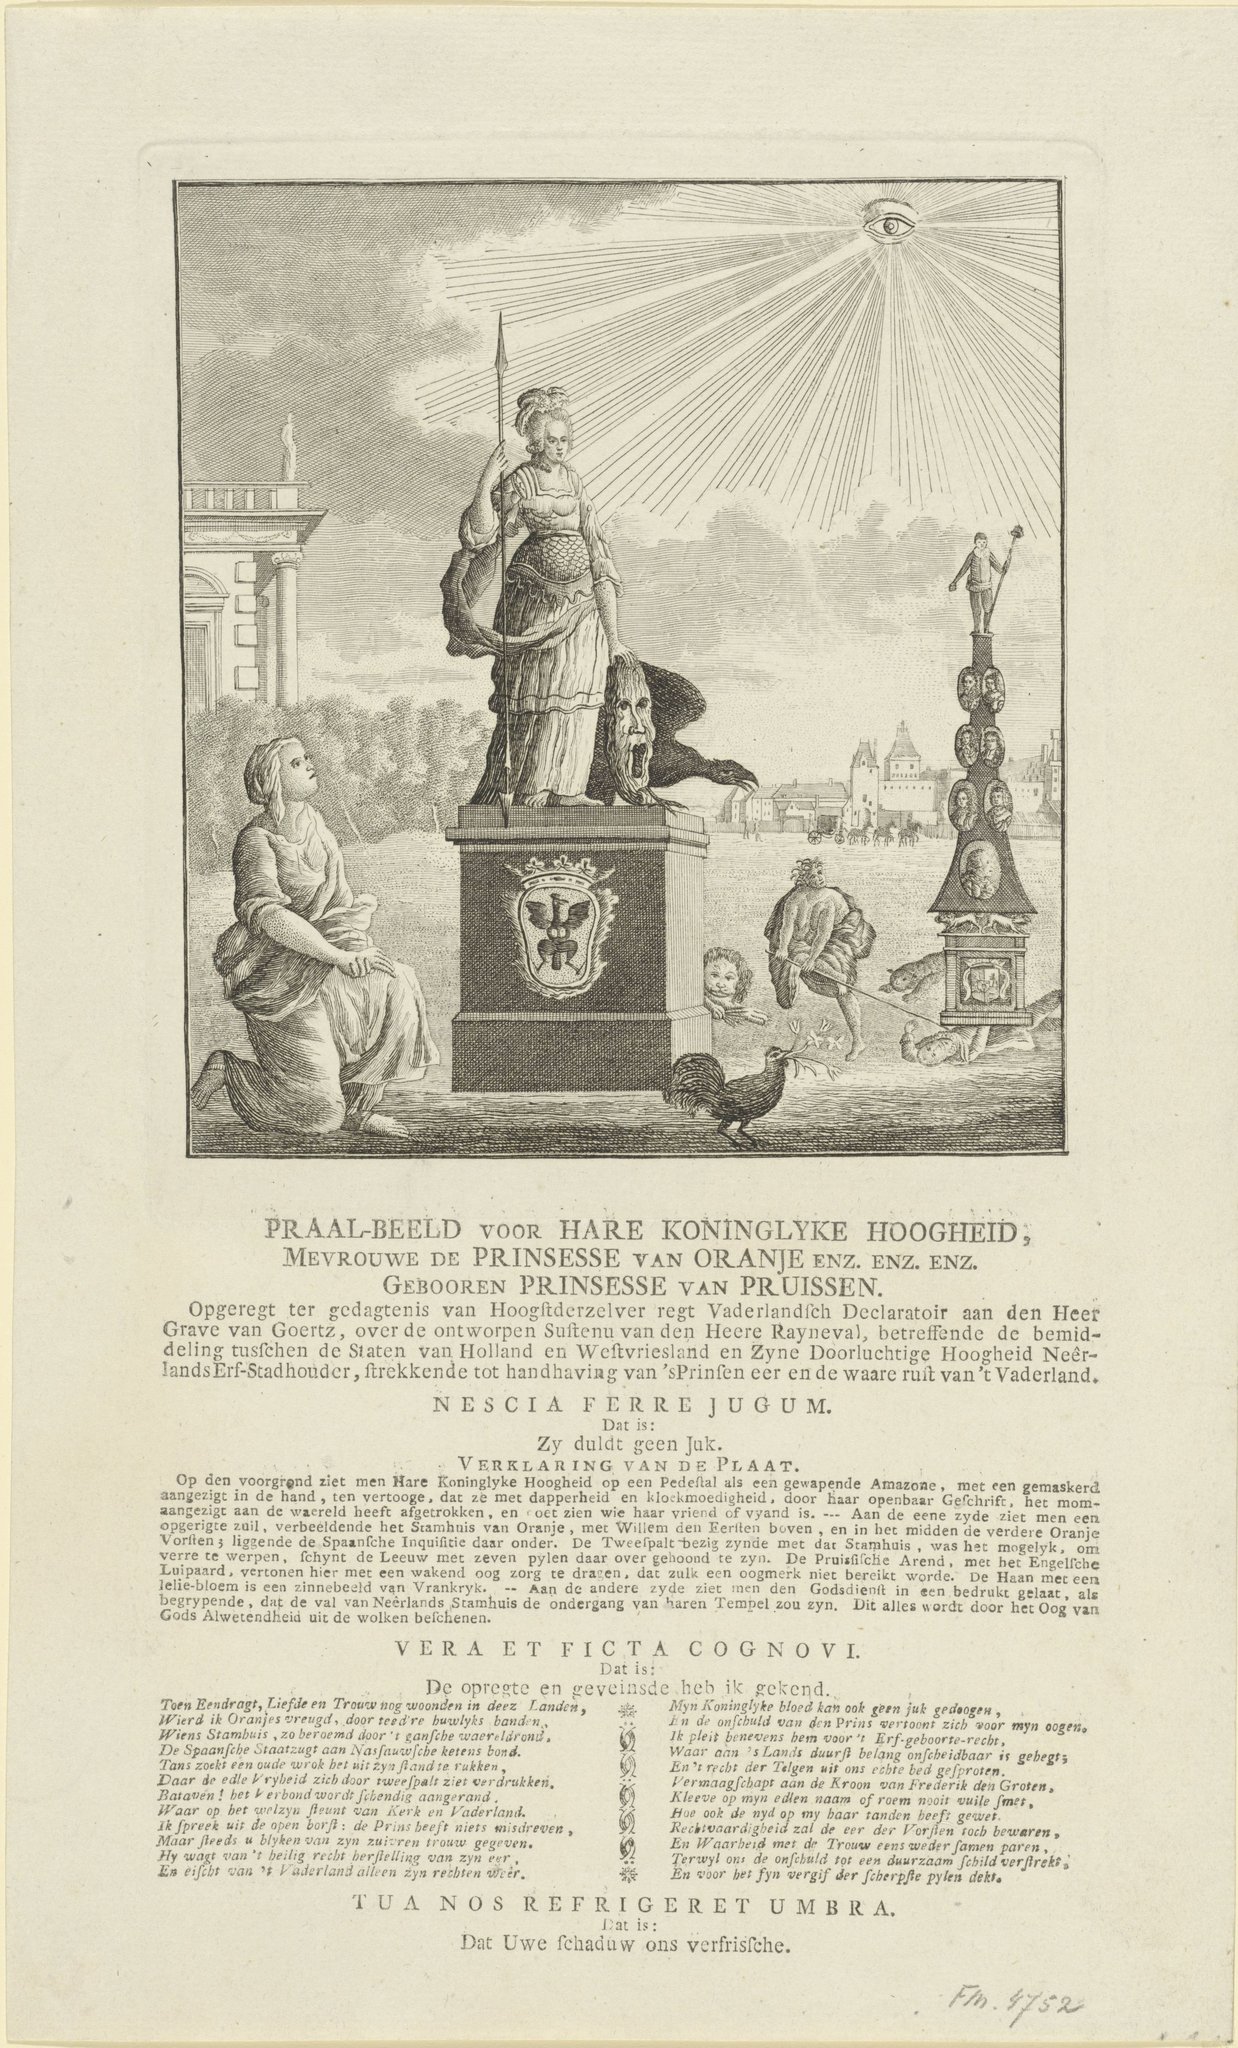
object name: print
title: Standbeeld voor Wilhelmina van Pruisen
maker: Anonymous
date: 1787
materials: paper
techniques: engraving, etching, letterpress printing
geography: northern netherlands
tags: berlin, painter, draughtsman, wilhelmina of prussia (princess of orange), monument, statue, the all-seeing eye, triangle with eye ~ symbol of god the father, homage to a ruler, patriots (1780-1795)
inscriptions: collector's mark: Lugt 2228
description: Allegrorisch standbeeld ter ere van van Wilhelmina, naar aanleiding van de bemiddeling tussen de Staten van Holland en West-Friesland en de erfstadhouder, 1786 (Tweede druk). Beeld van de prinses als een gewapende Amazone. Rechts een monument met de vorsten uit het stamhuis van Oranje, links knielt de Godsdienst. In de hemel het Alziende Oog. Op het blad onder de plaat een verklaring van de voorstelling en een vers in twee kolommen. Bij de plaat behoort een pendant.